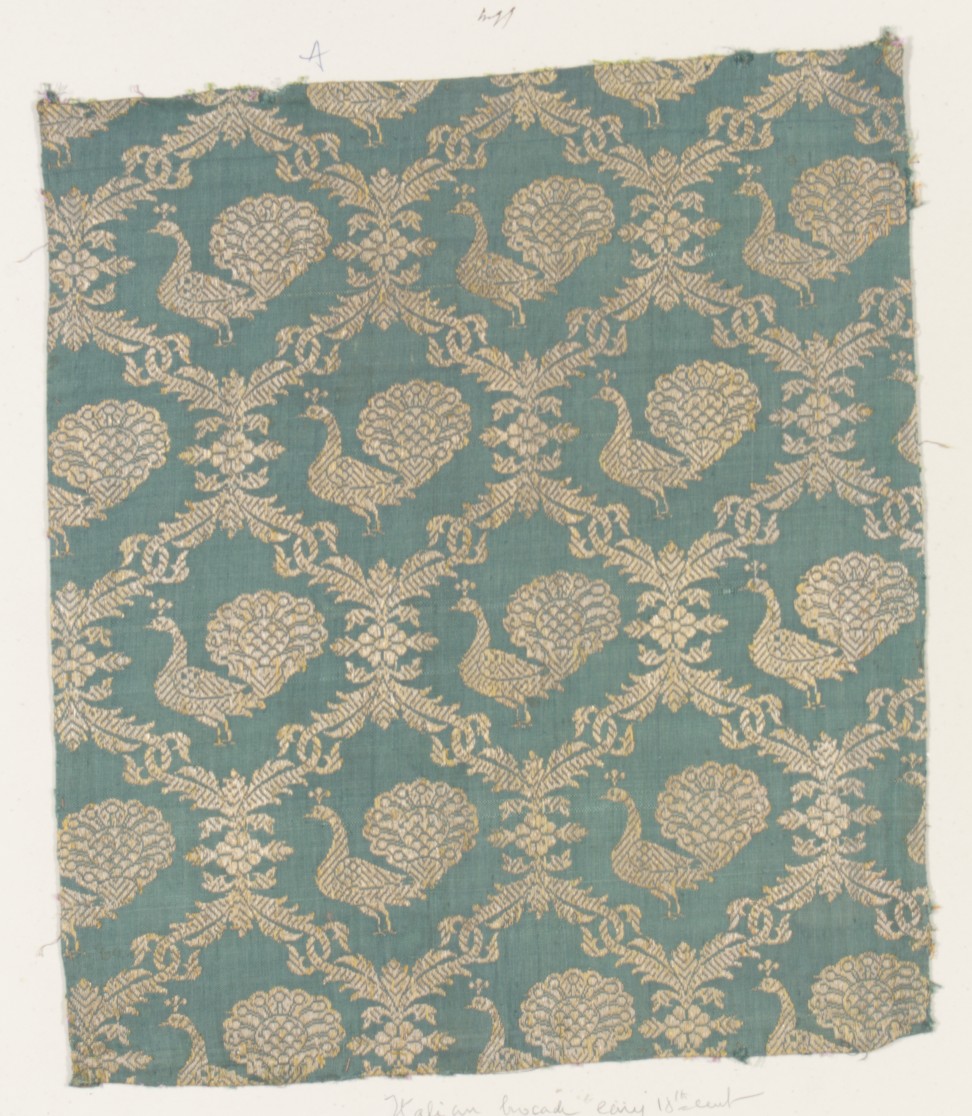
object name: fragment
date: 1701-1733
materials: metal thread, silk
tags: peacocks,flowers